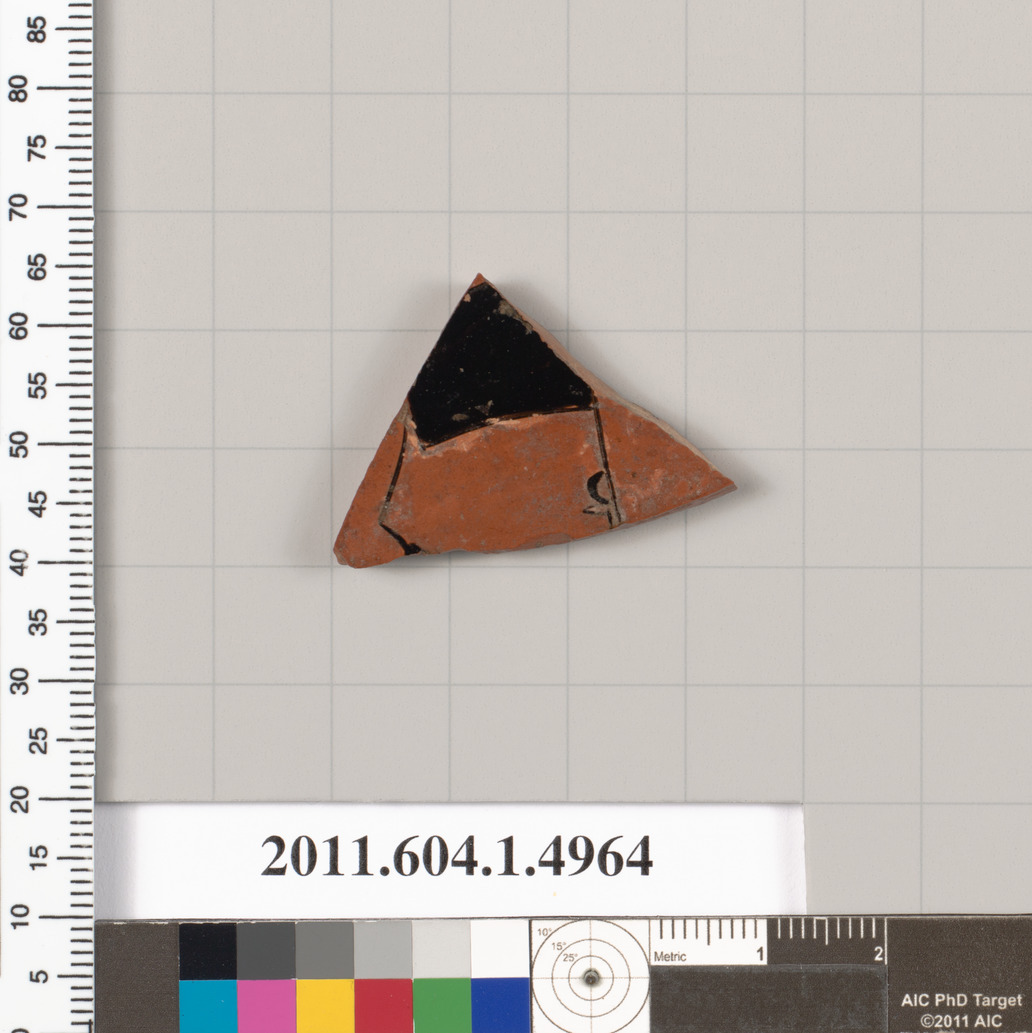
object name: kylix fragment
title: Terracotta fragment of a kylix (drinking cup)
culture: greek, attic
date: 510-490 BCE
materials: terracotta